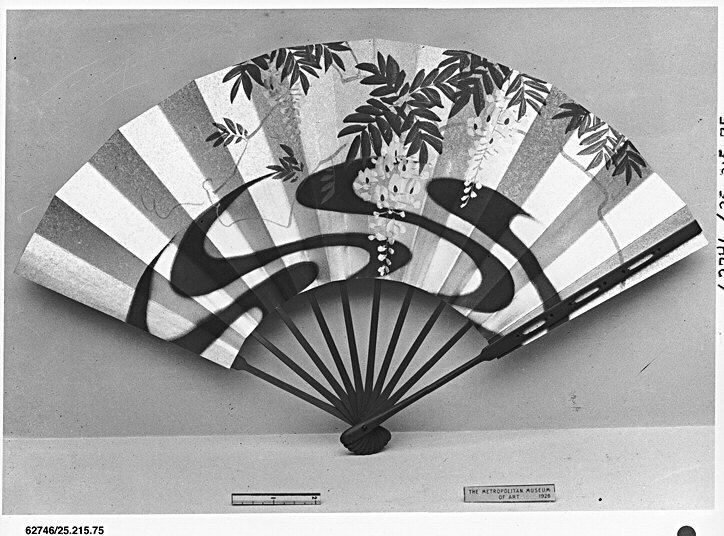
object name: folding fan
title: Fan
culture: japanese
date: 1901-2000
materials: metal, paint, paper